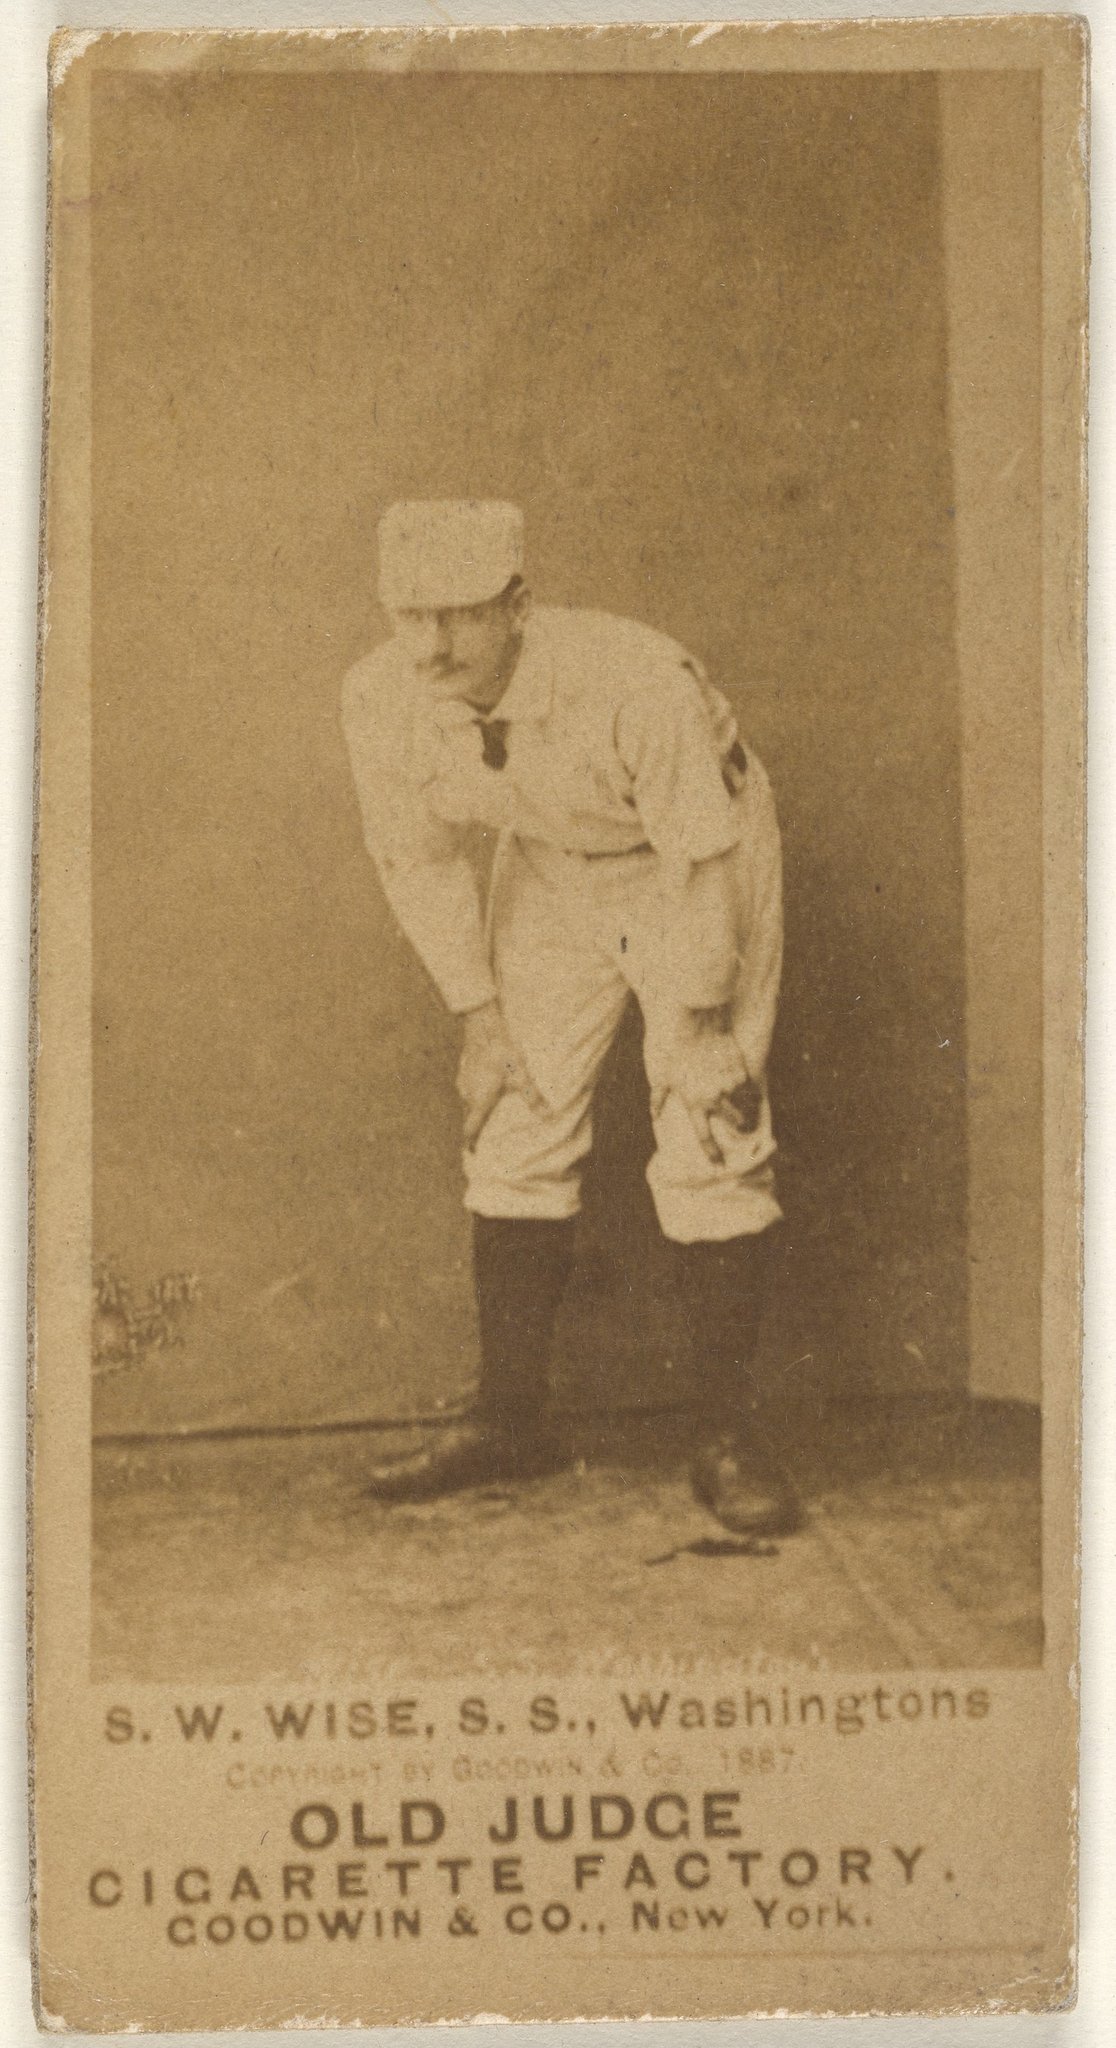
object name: baseball card, photograph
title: Samuel Washington "Sam" Wise, Shortstop, Washington Nationals, from the Old Judge series (N172) for Old Judge Cigarettes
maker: goodwin & company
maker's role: publisher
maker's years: 1850-1950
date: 1887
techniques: albumen silver print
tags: men,portraits,baseball,athletes